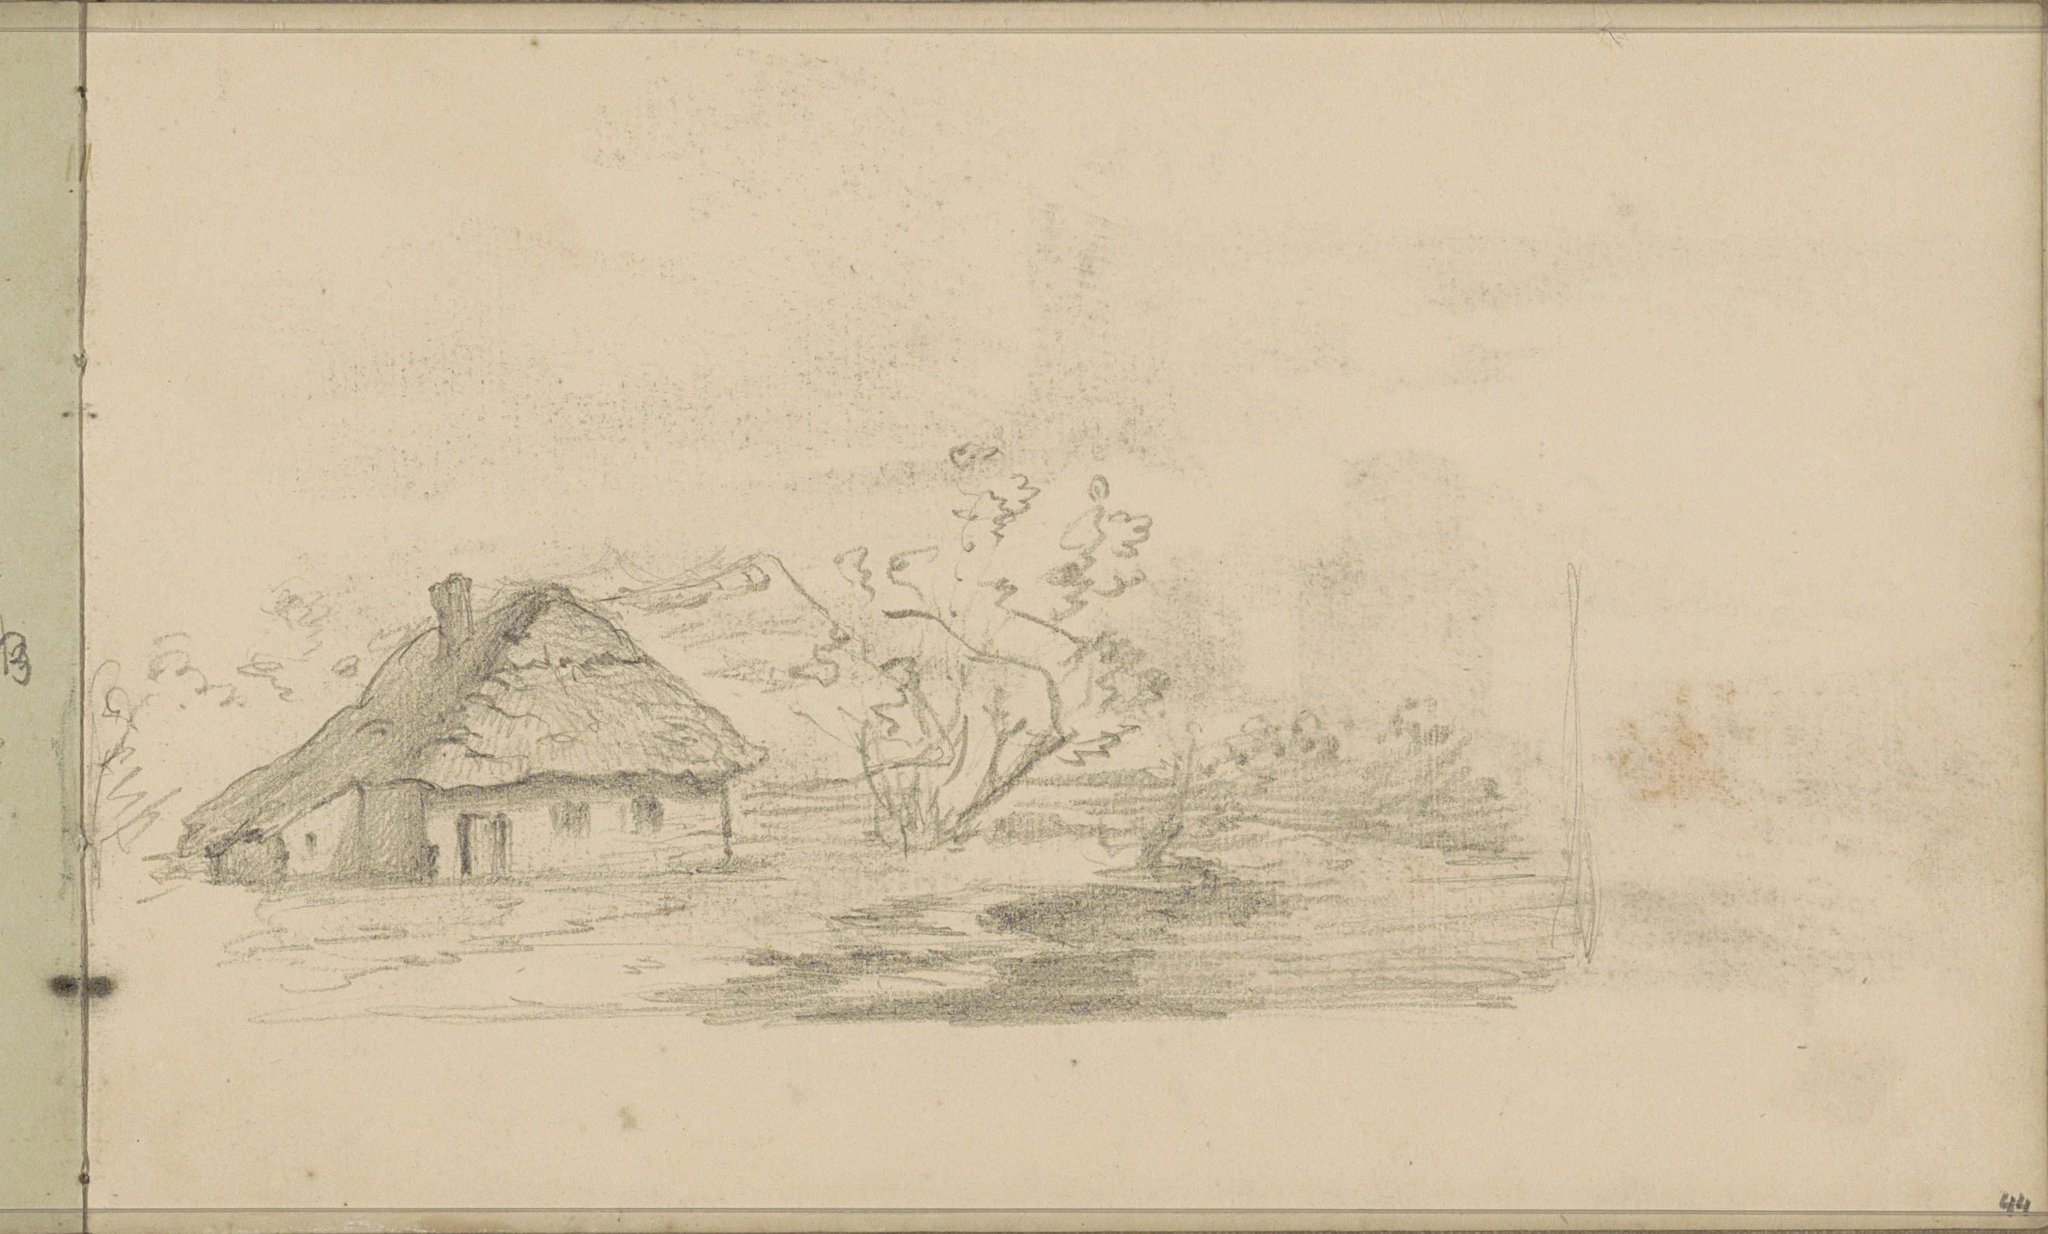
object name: sketchbook leaf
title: Boerderij met een rieten dak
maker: willem cornelis rip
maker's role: draughtsman, painter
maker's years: 1856-1922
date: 1874-1875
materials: paper, pencil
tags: farm (building)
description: Blad 44 recto uit een schetsboek met 46 bladen.